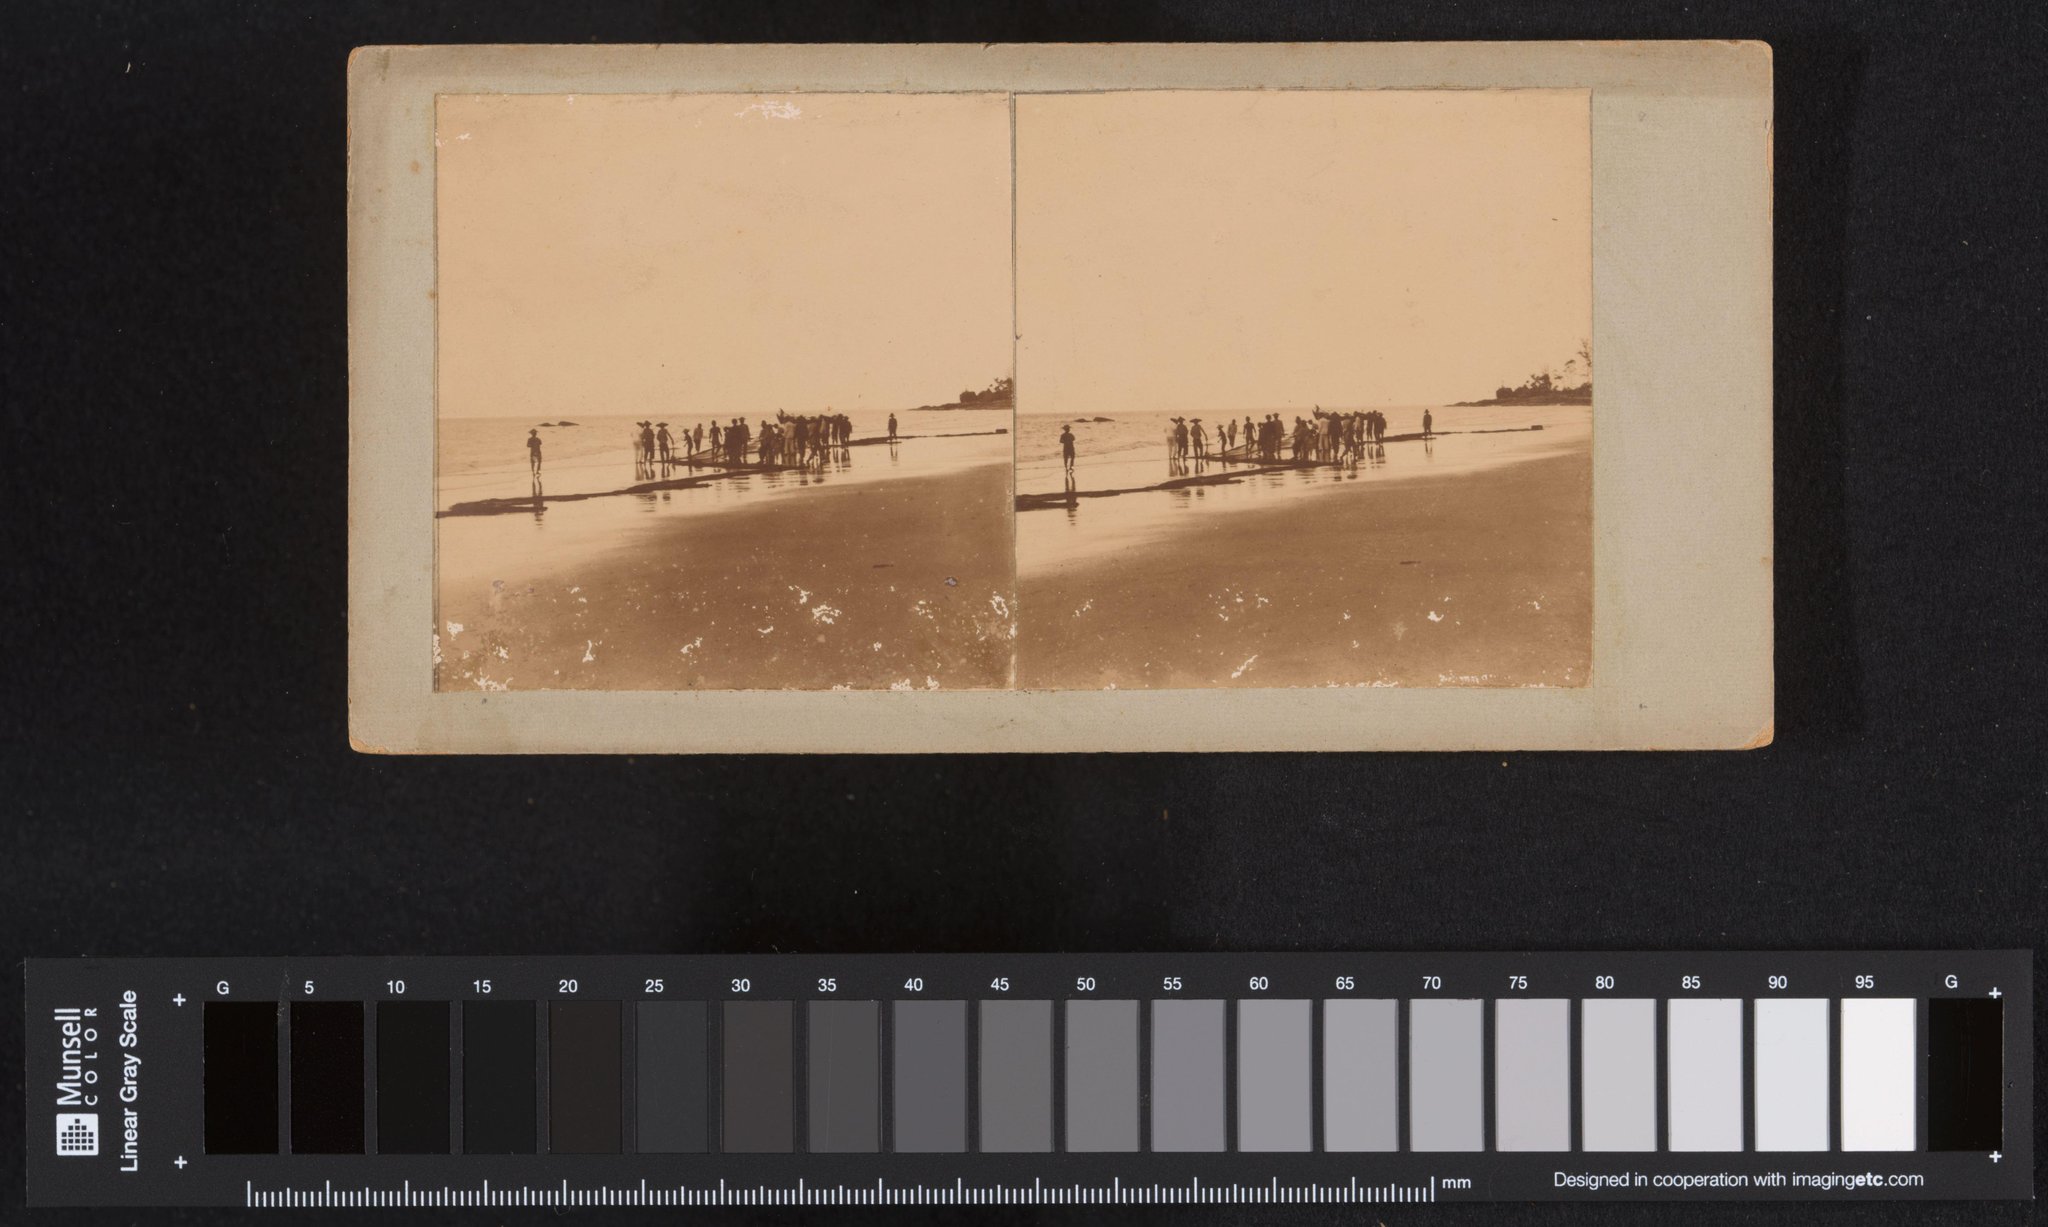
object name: stereograph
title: Inhalen van visnetten op het strand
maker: robert julius boers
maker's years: 1867-1932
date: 1900-1922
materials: cardboard, photographic support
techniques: gelatin silver print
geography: bangka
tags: robert julius boers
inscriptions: inscription: ‘Strandgezicht bij mijn 32 / Het inhalen der netten’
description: Strandgezicht met vissers die de netten binnenhalen, waarschijnlijk op Banka. Onderdeel van een groep stereofoto's van Robert Julius Boers, chef van het staatsbedrijf de Banka-tinwinning op Banka, uit de periode ca. 1900-1922.